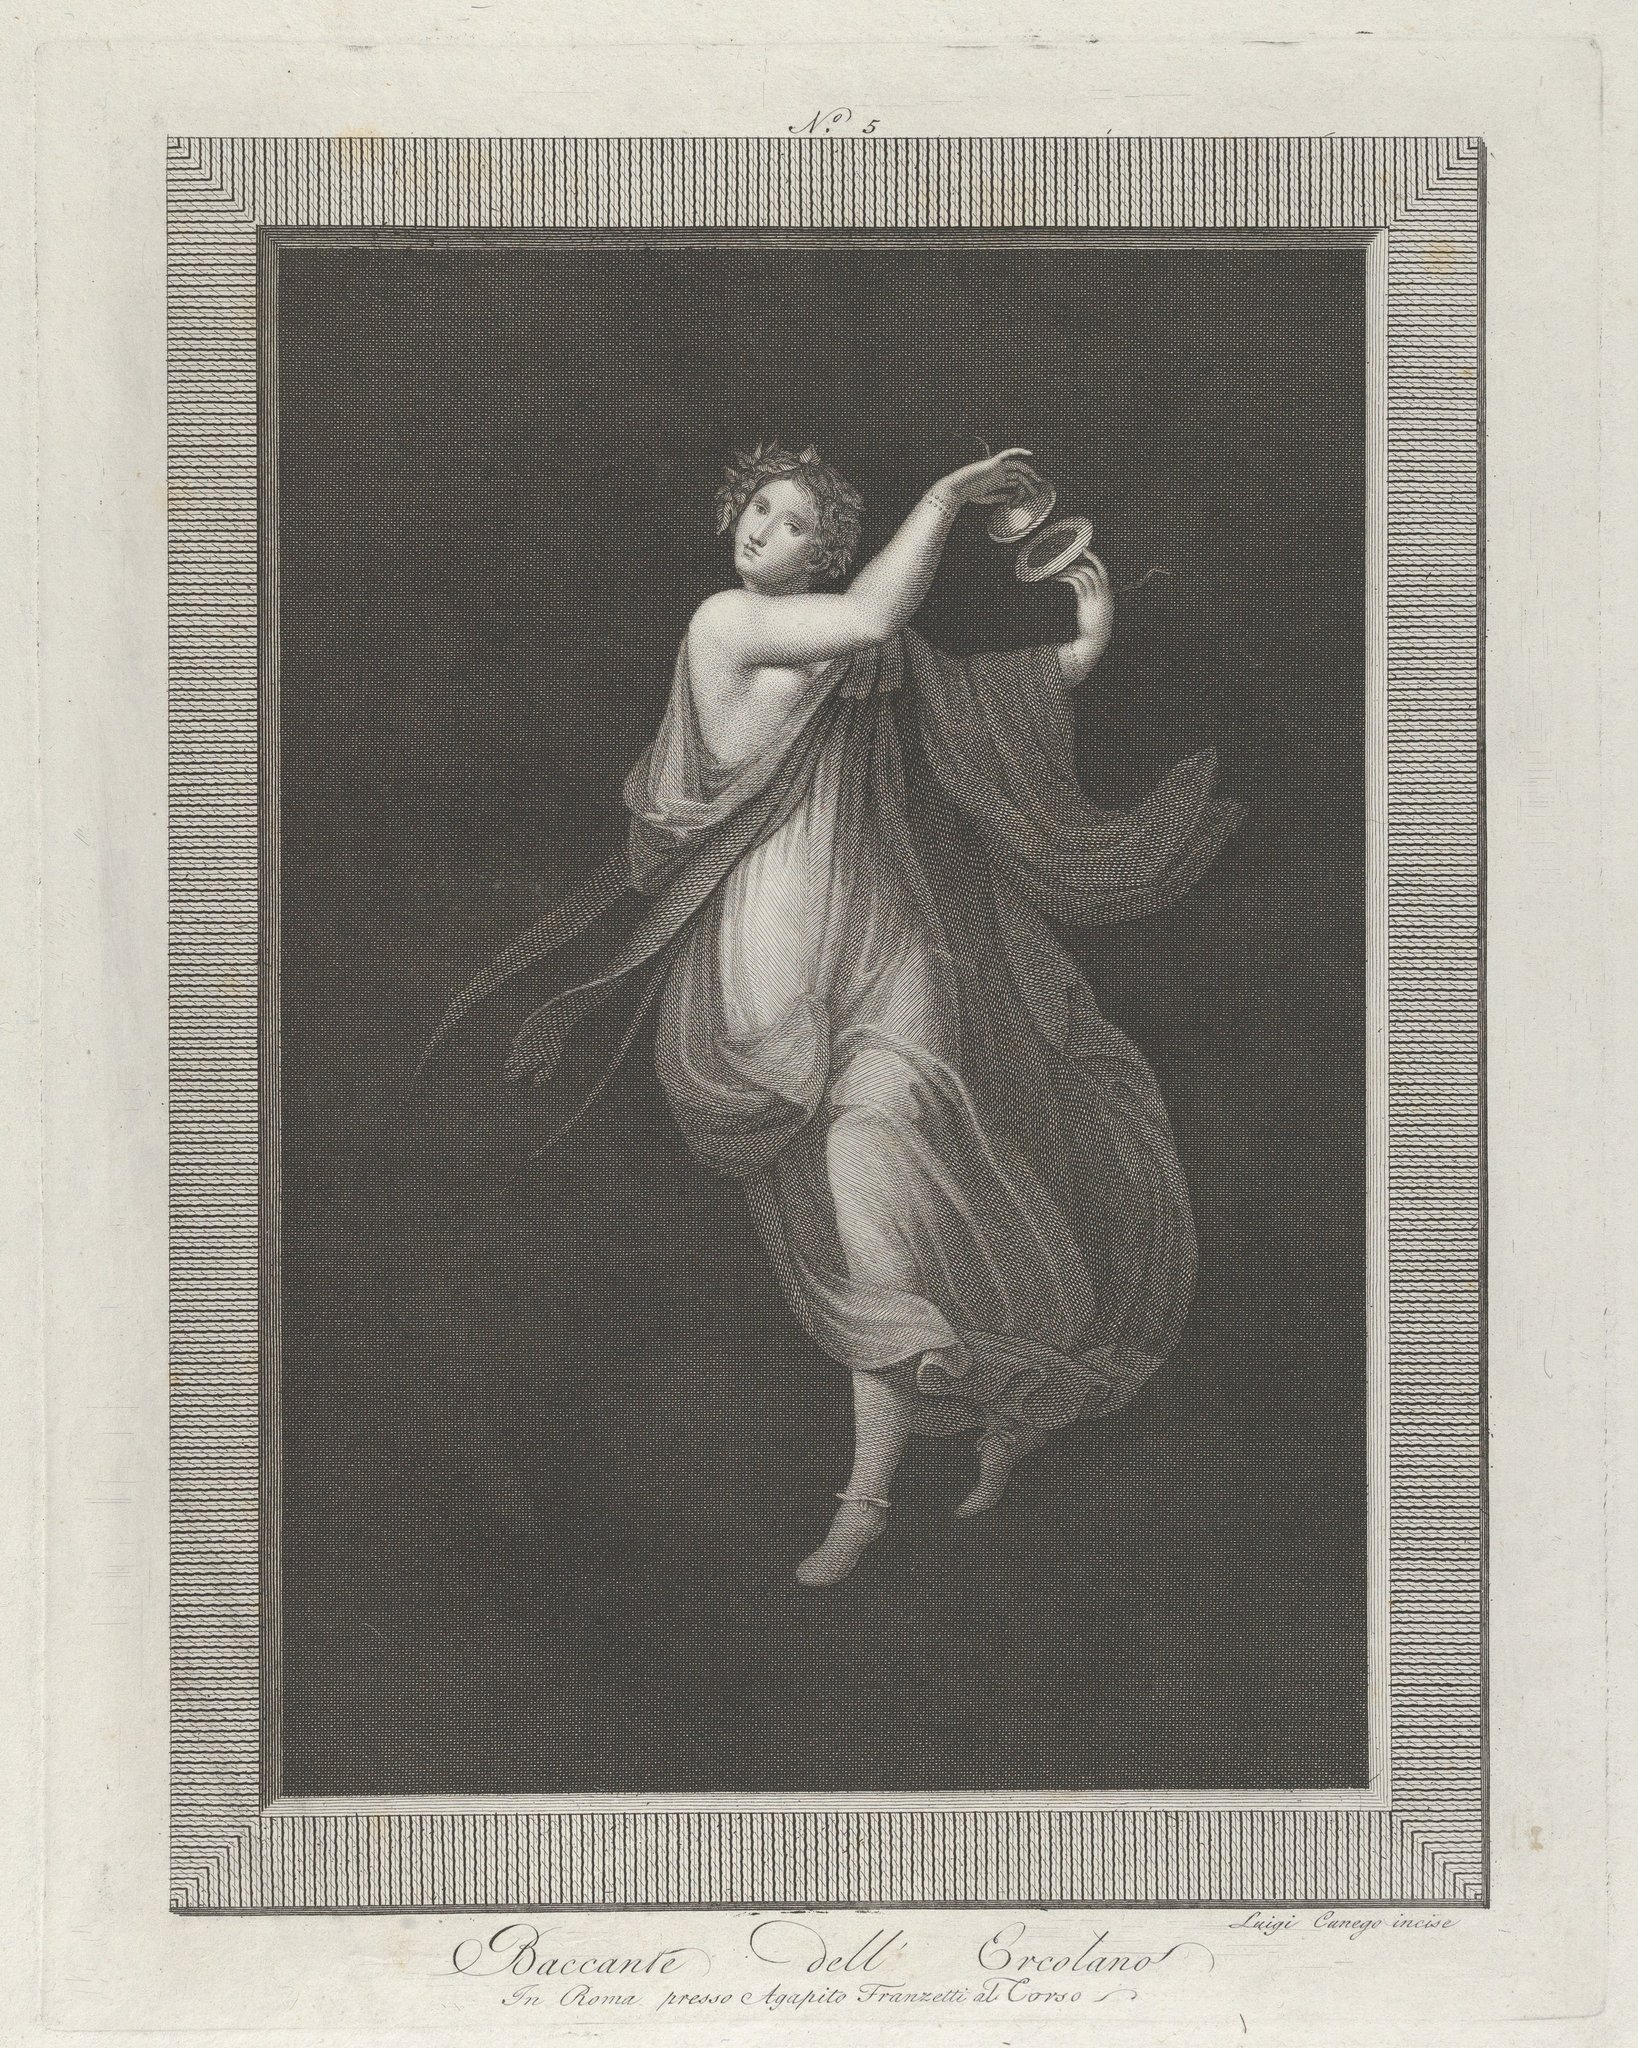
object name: print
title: A bacchante, a garland on her head, and playing cymbals, set against a black background inside a rectangular frame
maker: aloysio cunego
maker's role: artist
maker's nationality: italian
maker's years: 1757-1823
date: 1795-1820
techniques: engraving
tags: bacchantes